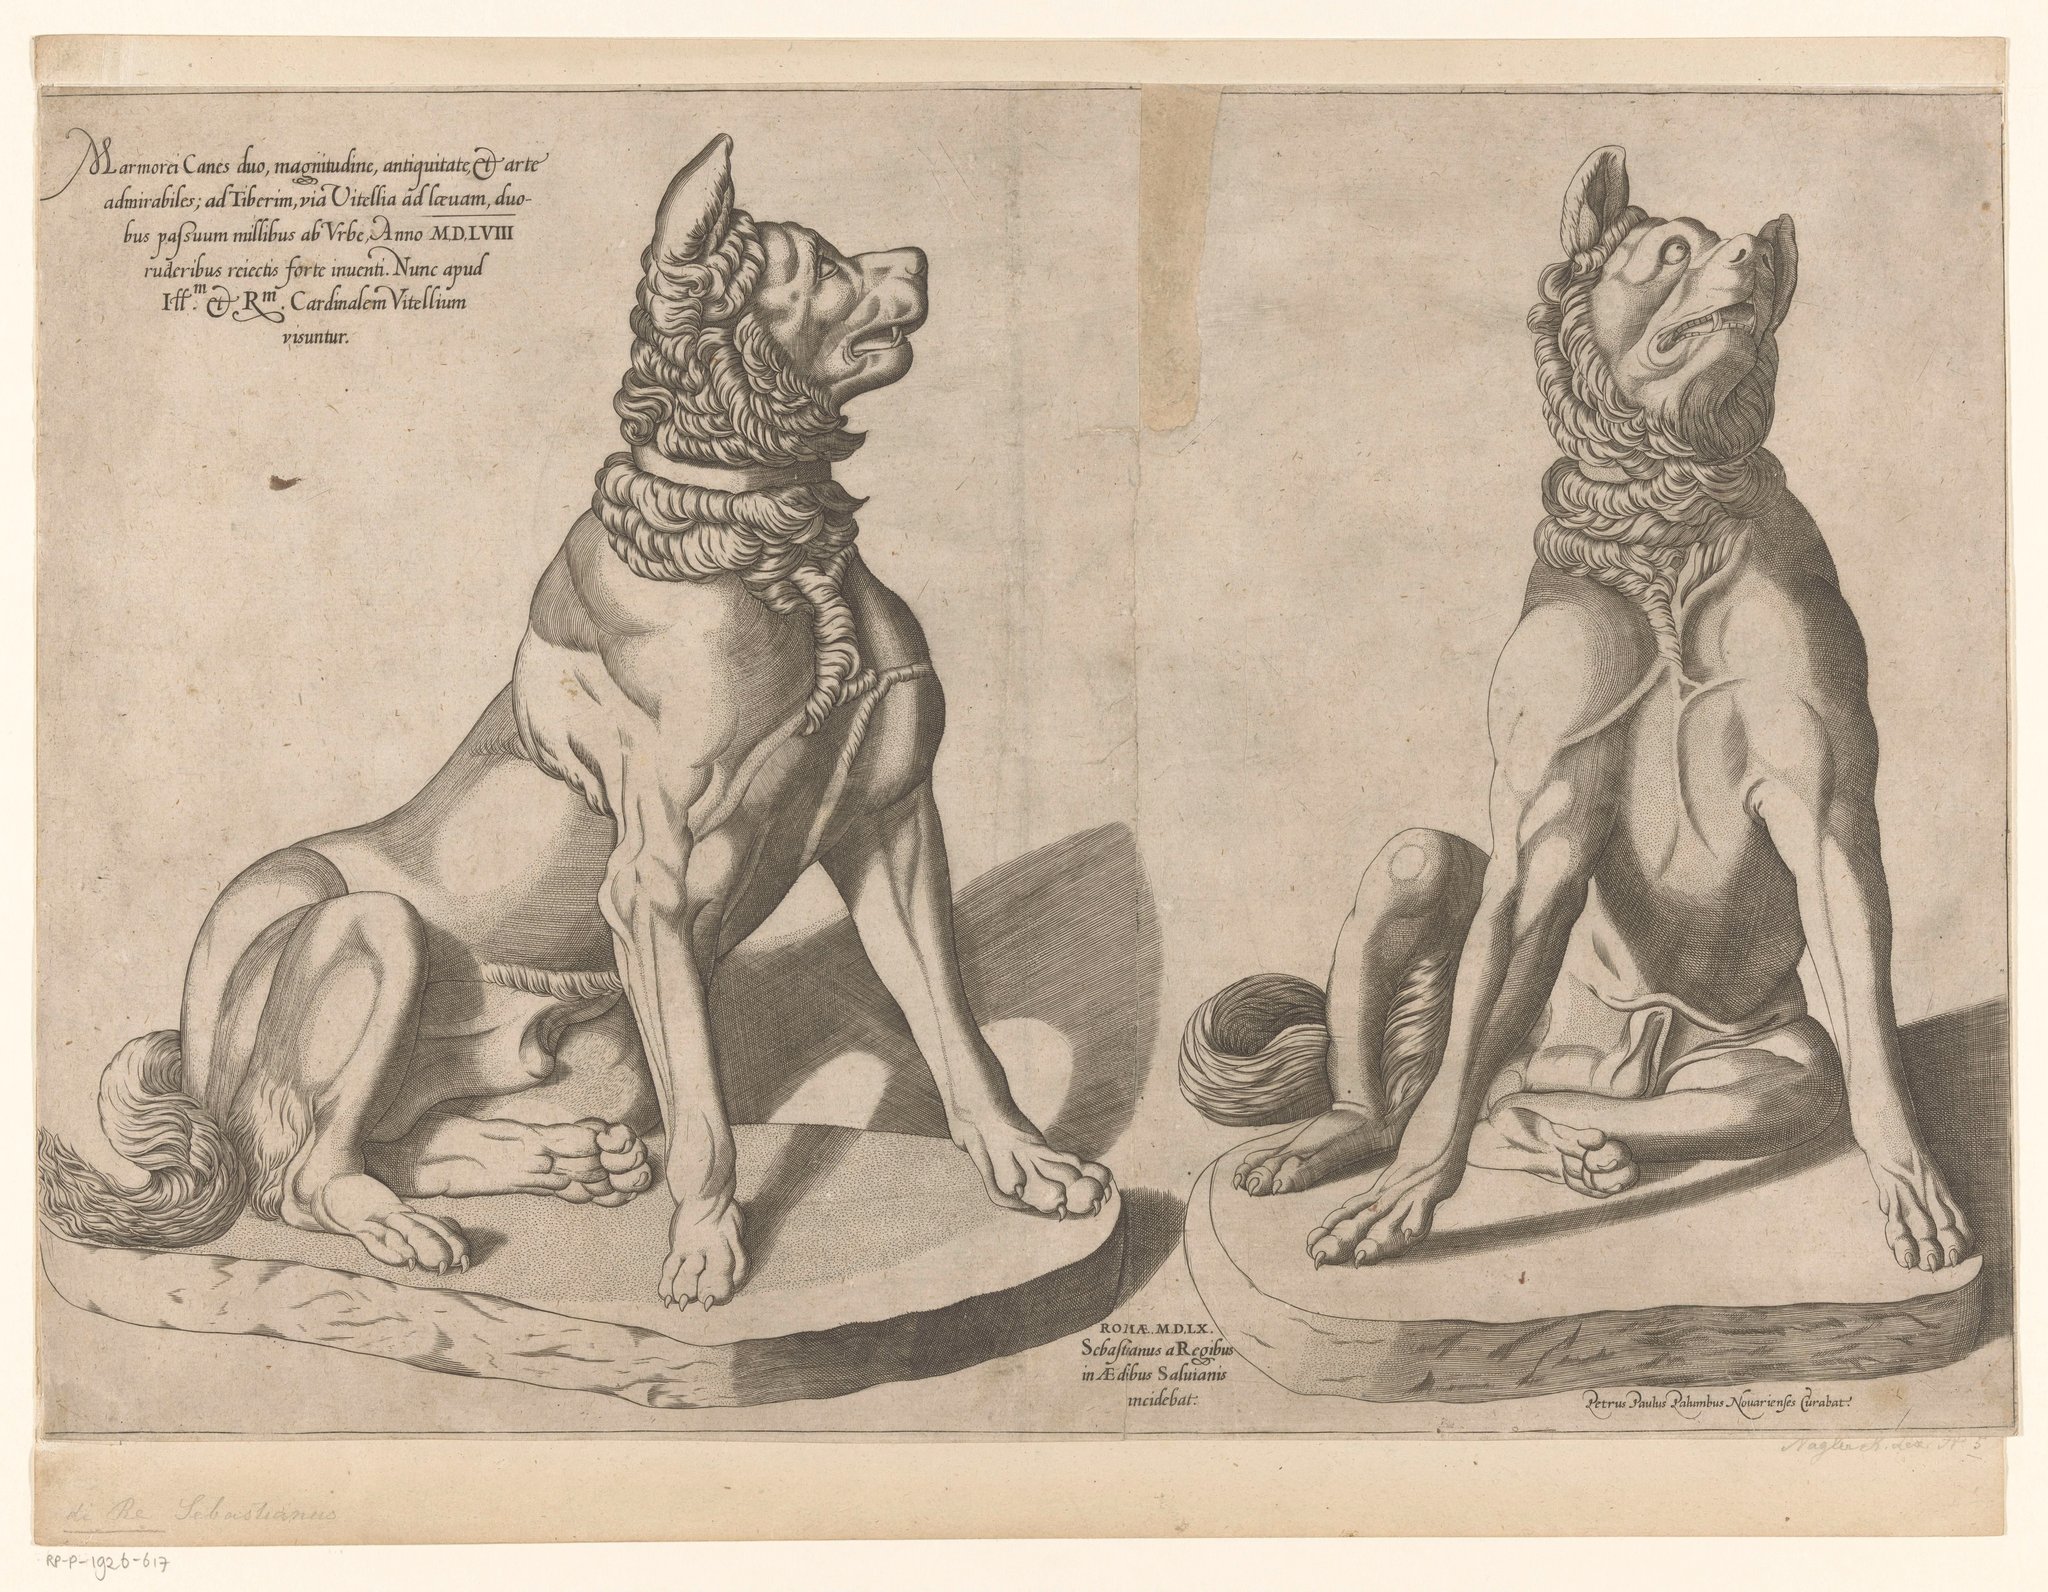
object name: print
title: Speculum Romanae Magnificentiae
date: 1560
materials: paper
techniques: engraving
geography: rome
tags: piece of sculpture, reproduction of a piece of sculpture, dog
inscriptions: collector's mark: Lugt 2166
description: De originele sculpturen bevinden zich in de Vestibolo d’entrata in de Galleria degli Uffizi (Ricetto Lorenese) in Florence (inv. nr.: 1914 n. 65-66). Deze prent behoort tot het prentcorpus dat bekend staat als de ‘Speculum Romanae Magnificentiae’ (‘Spiegel van Romeinse pracht’). Dit corpus, bestaande uit prenten met voorstellingen van kunstwerken en gebouwen uit het antieke en het moderne Rome, vond zijn oorsprong bij uitgevers Antonio Salamanca en Antonio Lafreri. Deze twee buitenlandse uitgevers bundelden hun krachten te Rome in de periode 1553-1563. Hun prenten werden al snel razend populair bij toeristen en verzamelaars, die de prenten individueel of in grote groepen aanschaften. Grote groepen Speculum-prenten werden vaak op aanvraag samengebonden in albums. Er zijn verschillende Speculum-albums overgeleverd die allemaal verschillen van inhoud. Tussen 1573 en 1577 gaf Antonio Lafreri een speciale titelpagina uit (met de titel ‘Speculum Romanae Magnificentiae’) die mensen voor hun verzamelingen konden voegen. Het overlijden van Lafreri in 1577 betekende niet het einde van het corpus. Een groot deel van de koperplaten ging over op Claudio en Stefano Duchetti. De rest raakte verspreid over verschillende andere uitgevers. De populariteit van de Speculum-prenten wist nog geruime periode uitgevers te inspireren tot het laten maken van kopieën en het toevoegen van nieuwe prenten aan het corpus.